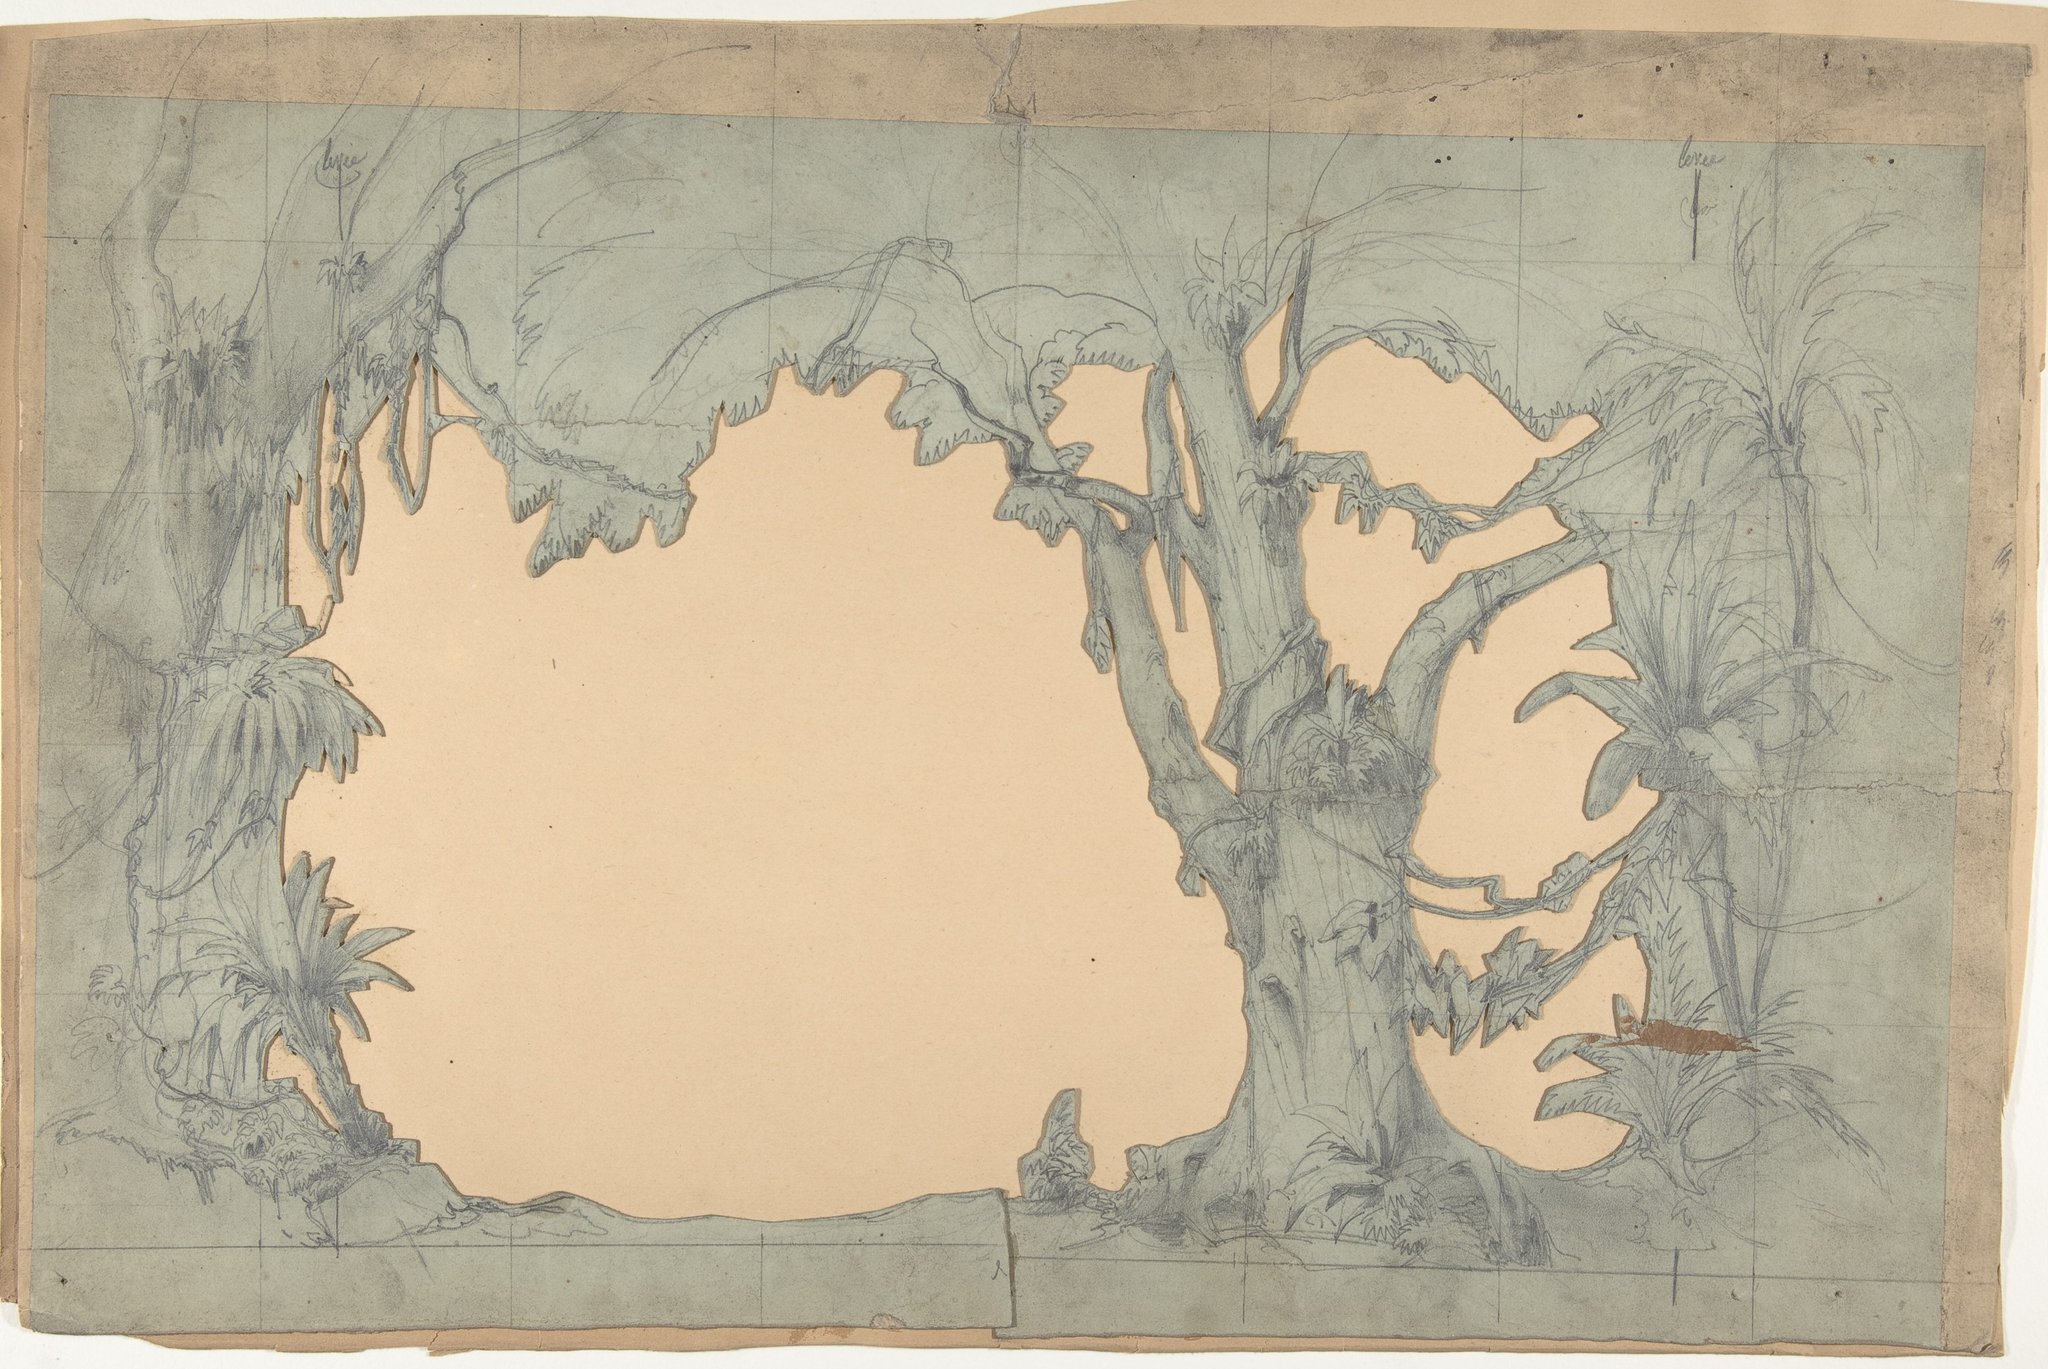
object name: drawing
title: Design for a Stage Set at the Opéra, Paris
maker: eugène cicéri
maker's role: artist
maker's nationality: french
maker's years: 1813-1890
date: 1830-1890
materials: graphite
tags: trees,stage design